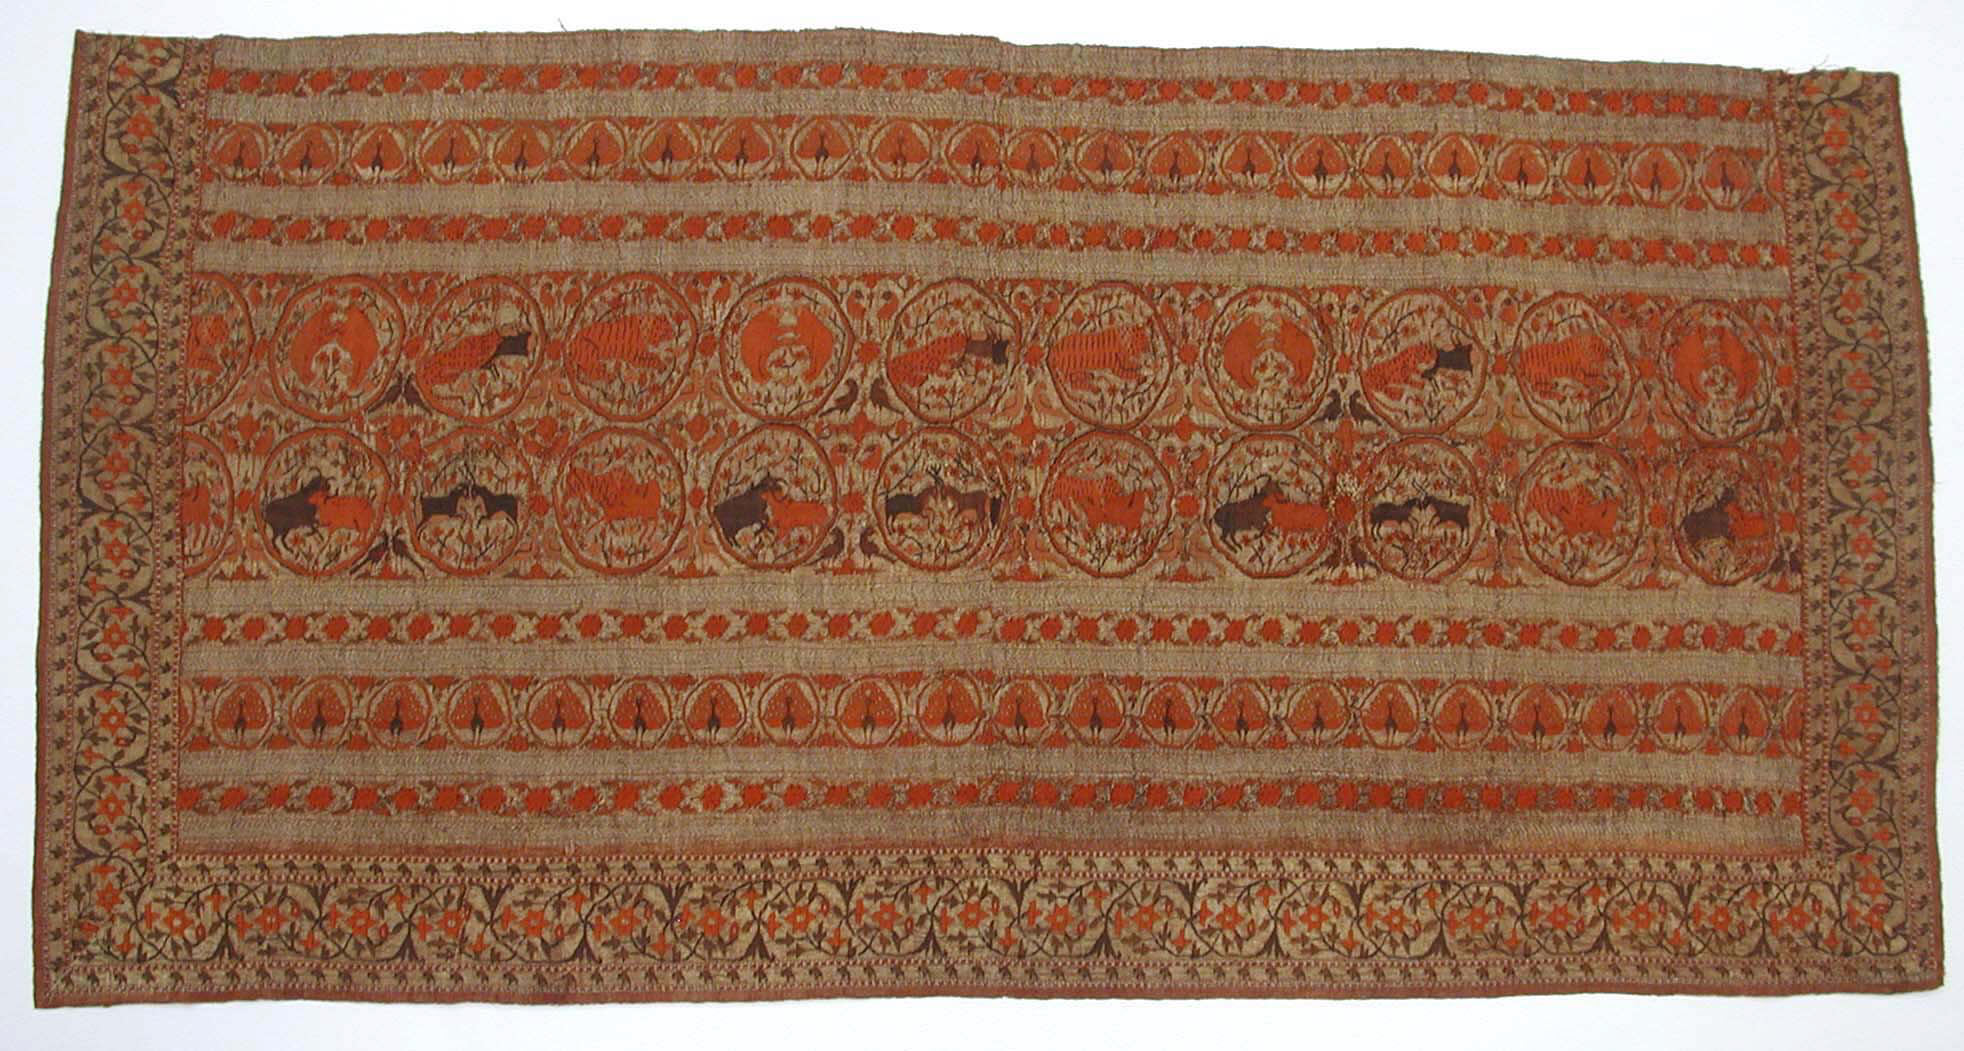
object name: sari border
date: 1701-1800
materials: gold, silk, silver, thread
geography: india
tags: animals,birds,flowers